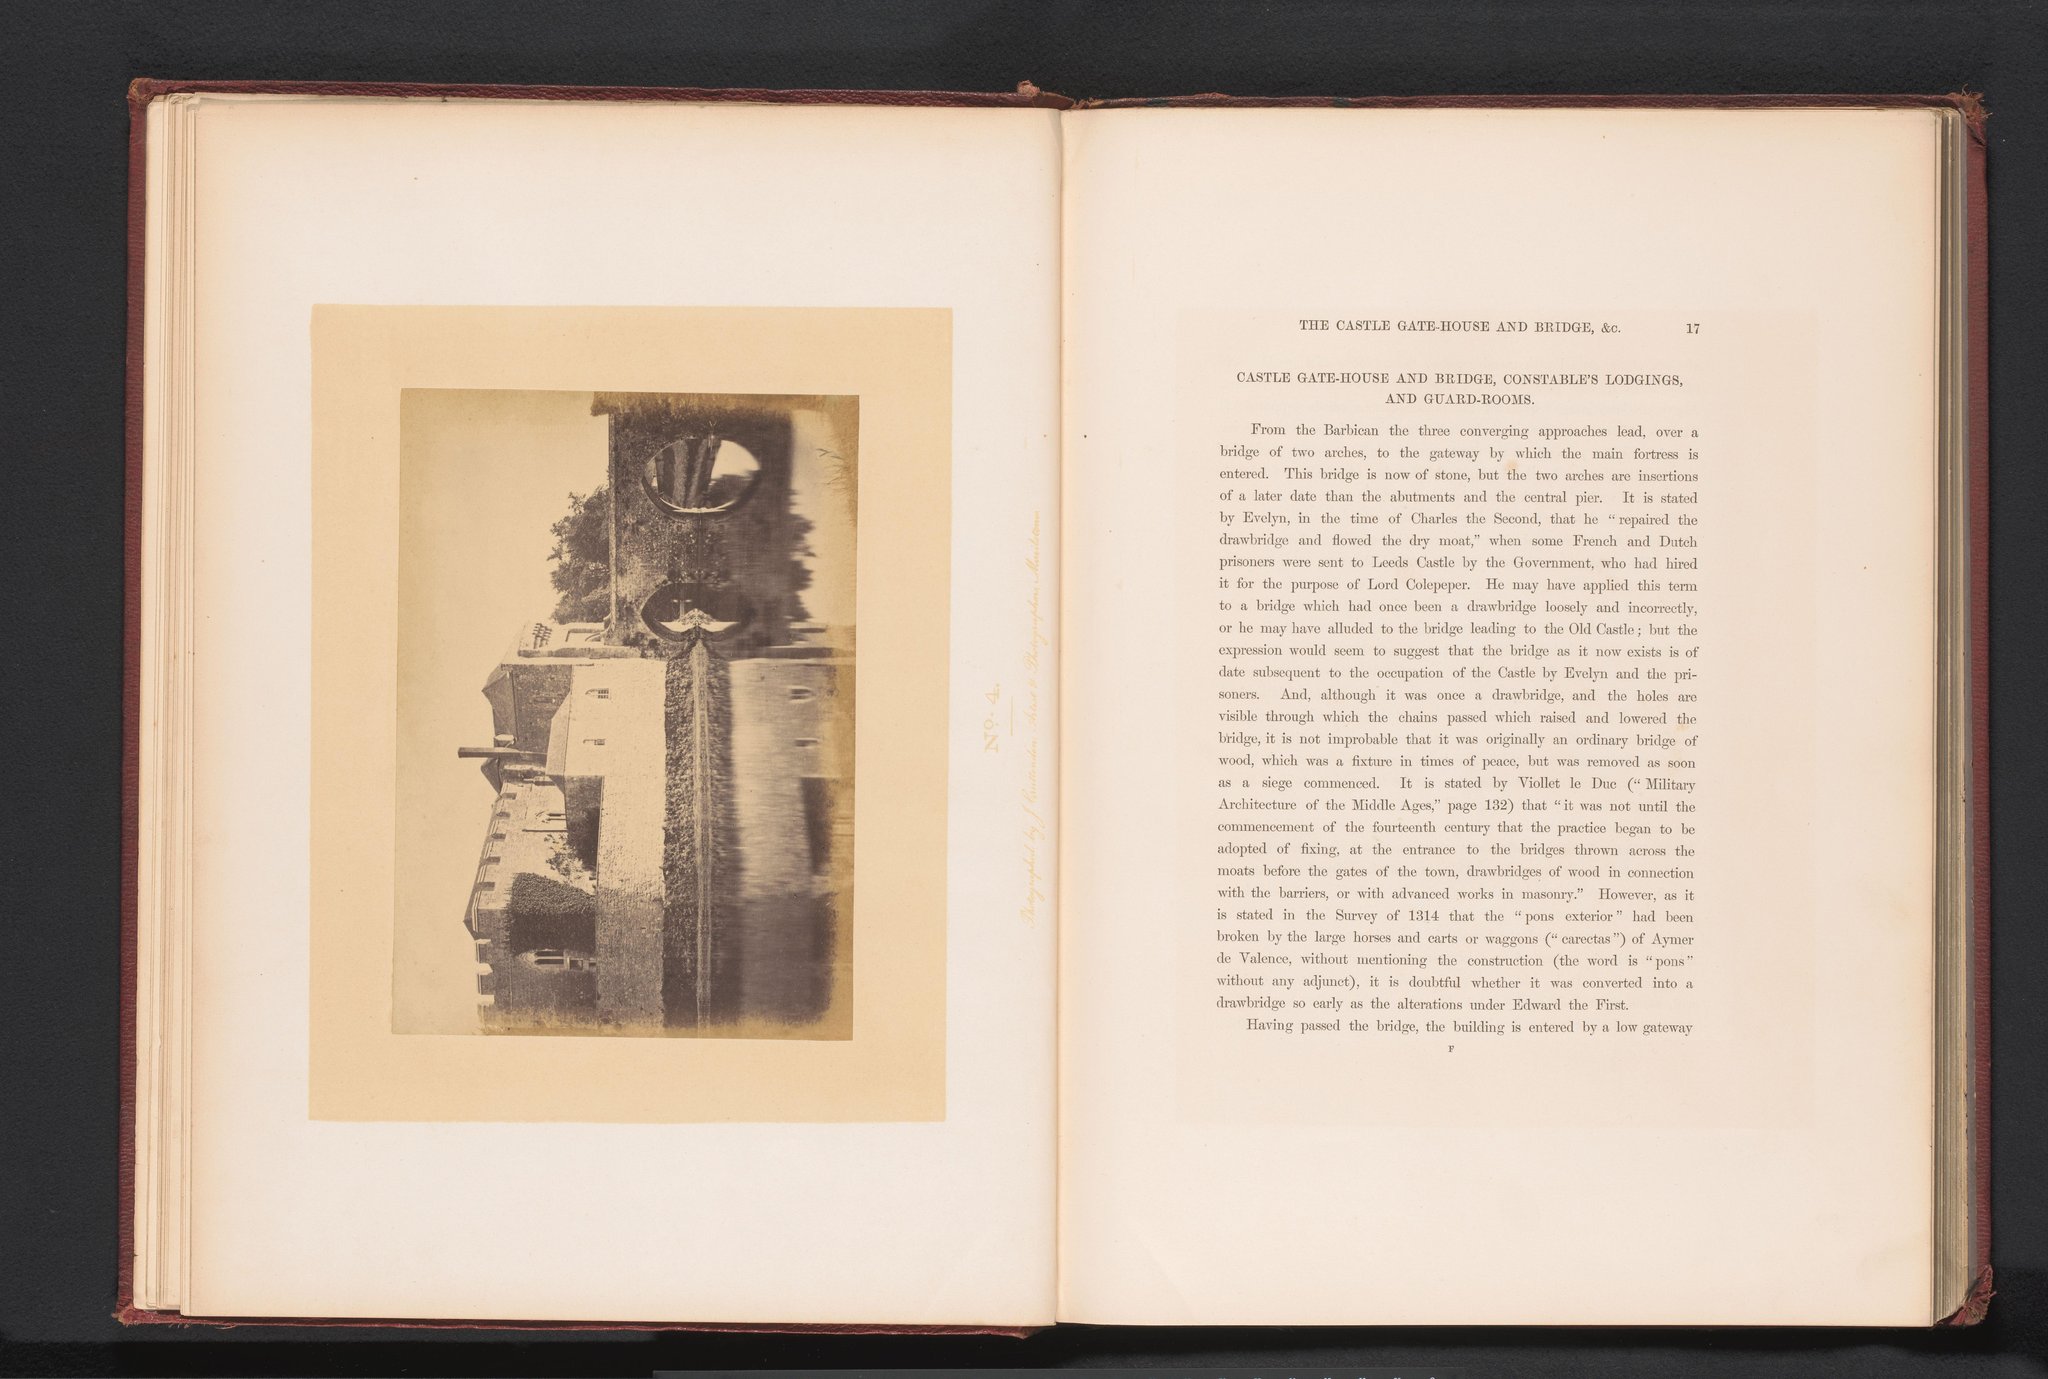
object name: photograph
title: Poortgebouw en brug van Leeds Castle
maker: john cruttenden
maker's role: fotograaf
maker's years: 1825-1892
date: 1864-1869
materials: photographic support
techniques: albumen print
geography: leeds castle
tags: castle, gate, entrance, landscape with tower or castle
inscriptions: inscription: ‘No.4.’